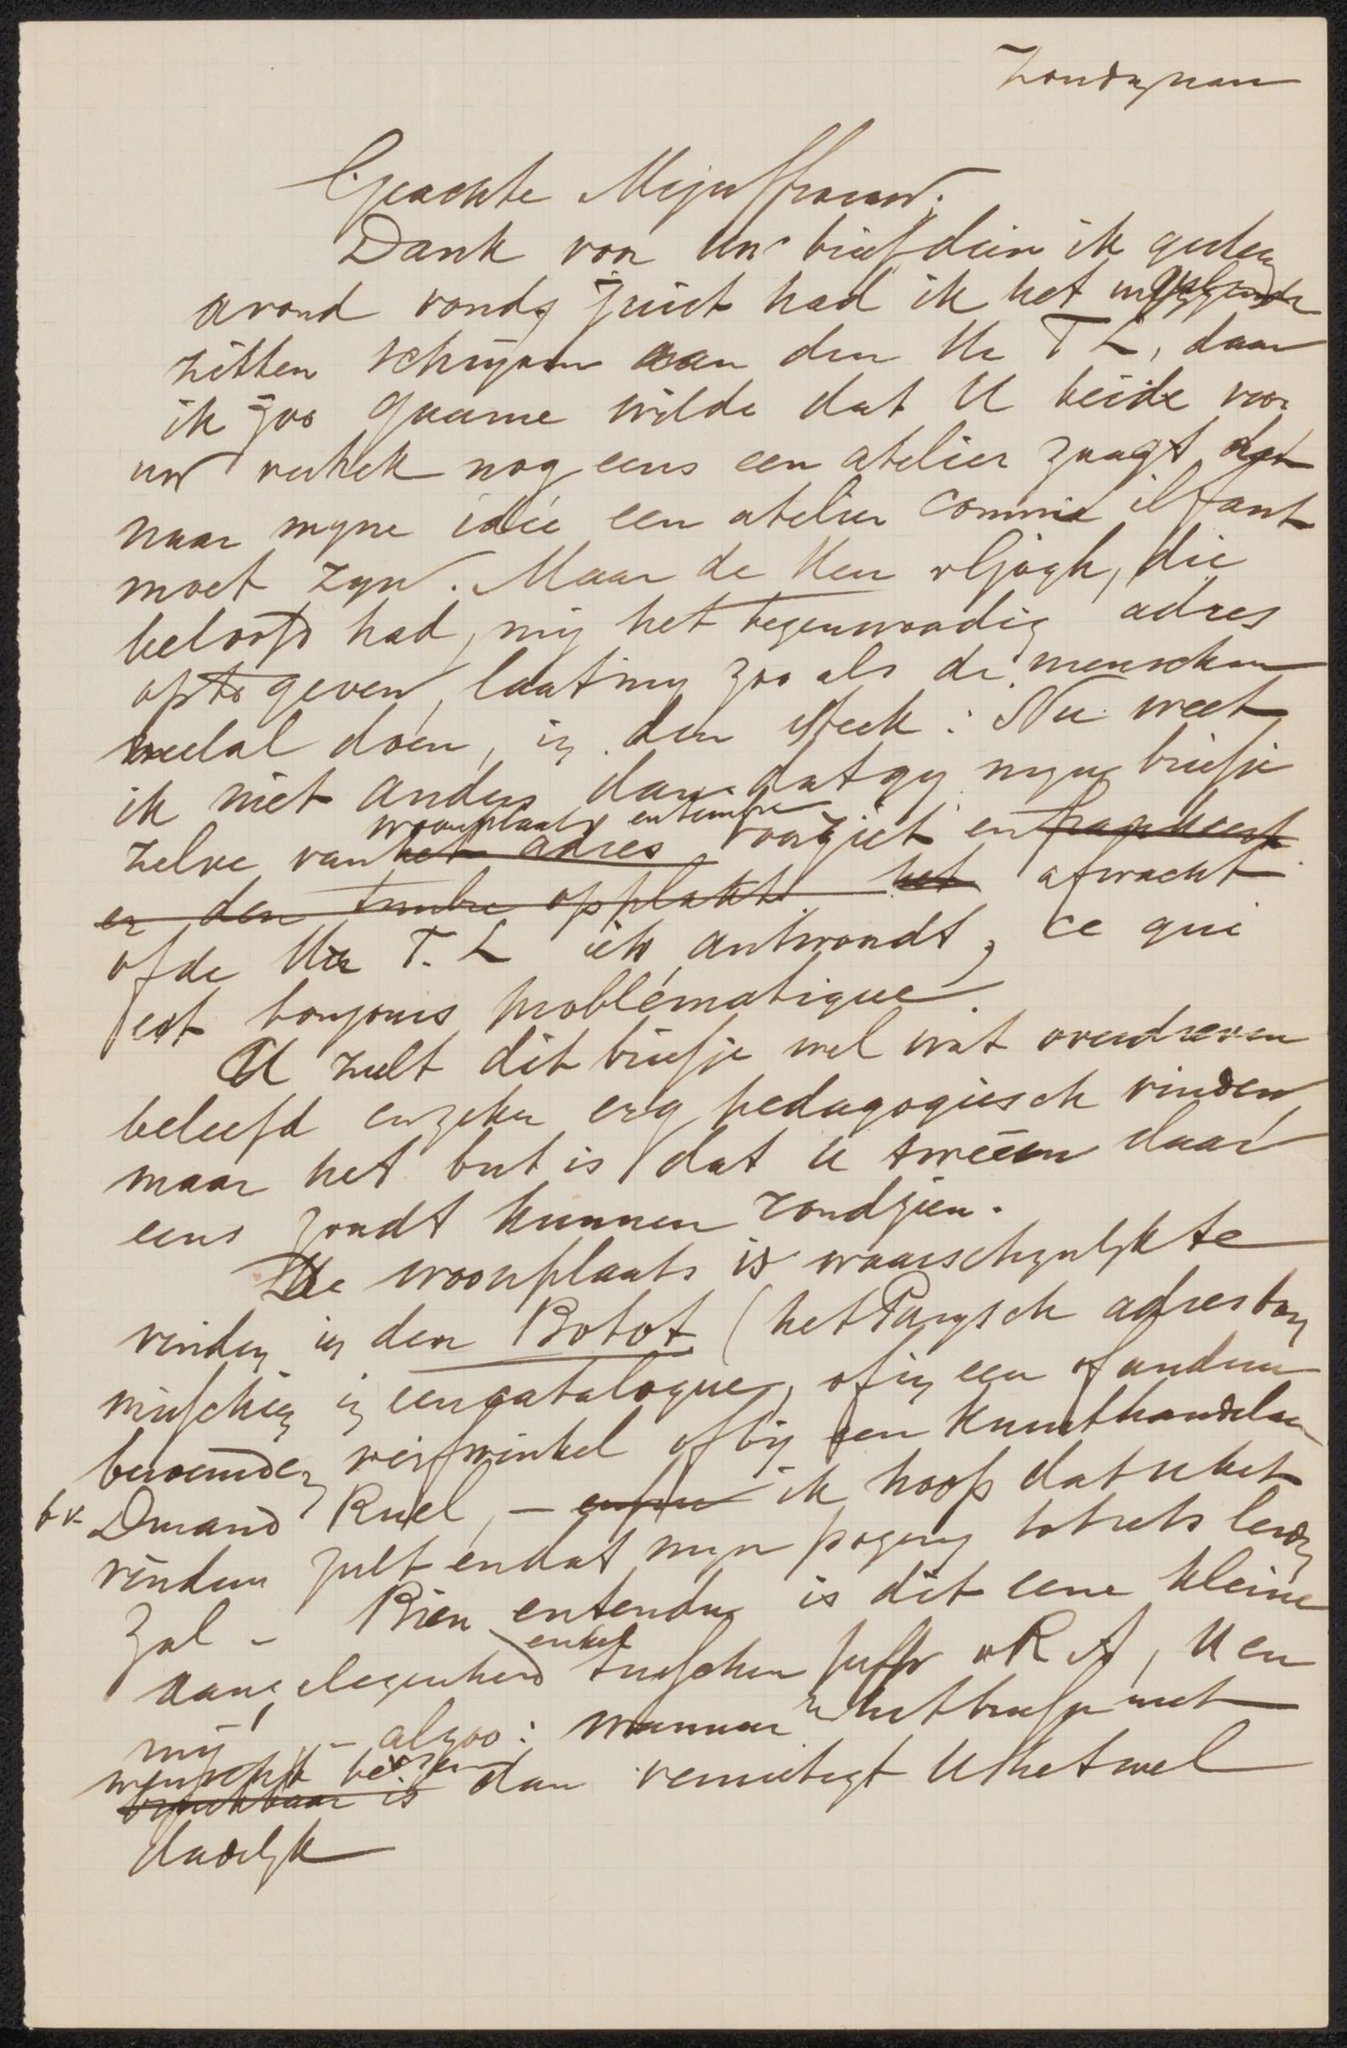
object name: letter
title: Conceptbrief aan anoniem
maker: august allebé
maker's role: draughtsman, print maker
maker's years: 1838-1927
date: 1848-1927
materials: ink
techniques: pen, writing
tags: amsterdam, painter, print maker, draughtsman, marie van regteren altena, workshop, studio of the artist (in general), paris